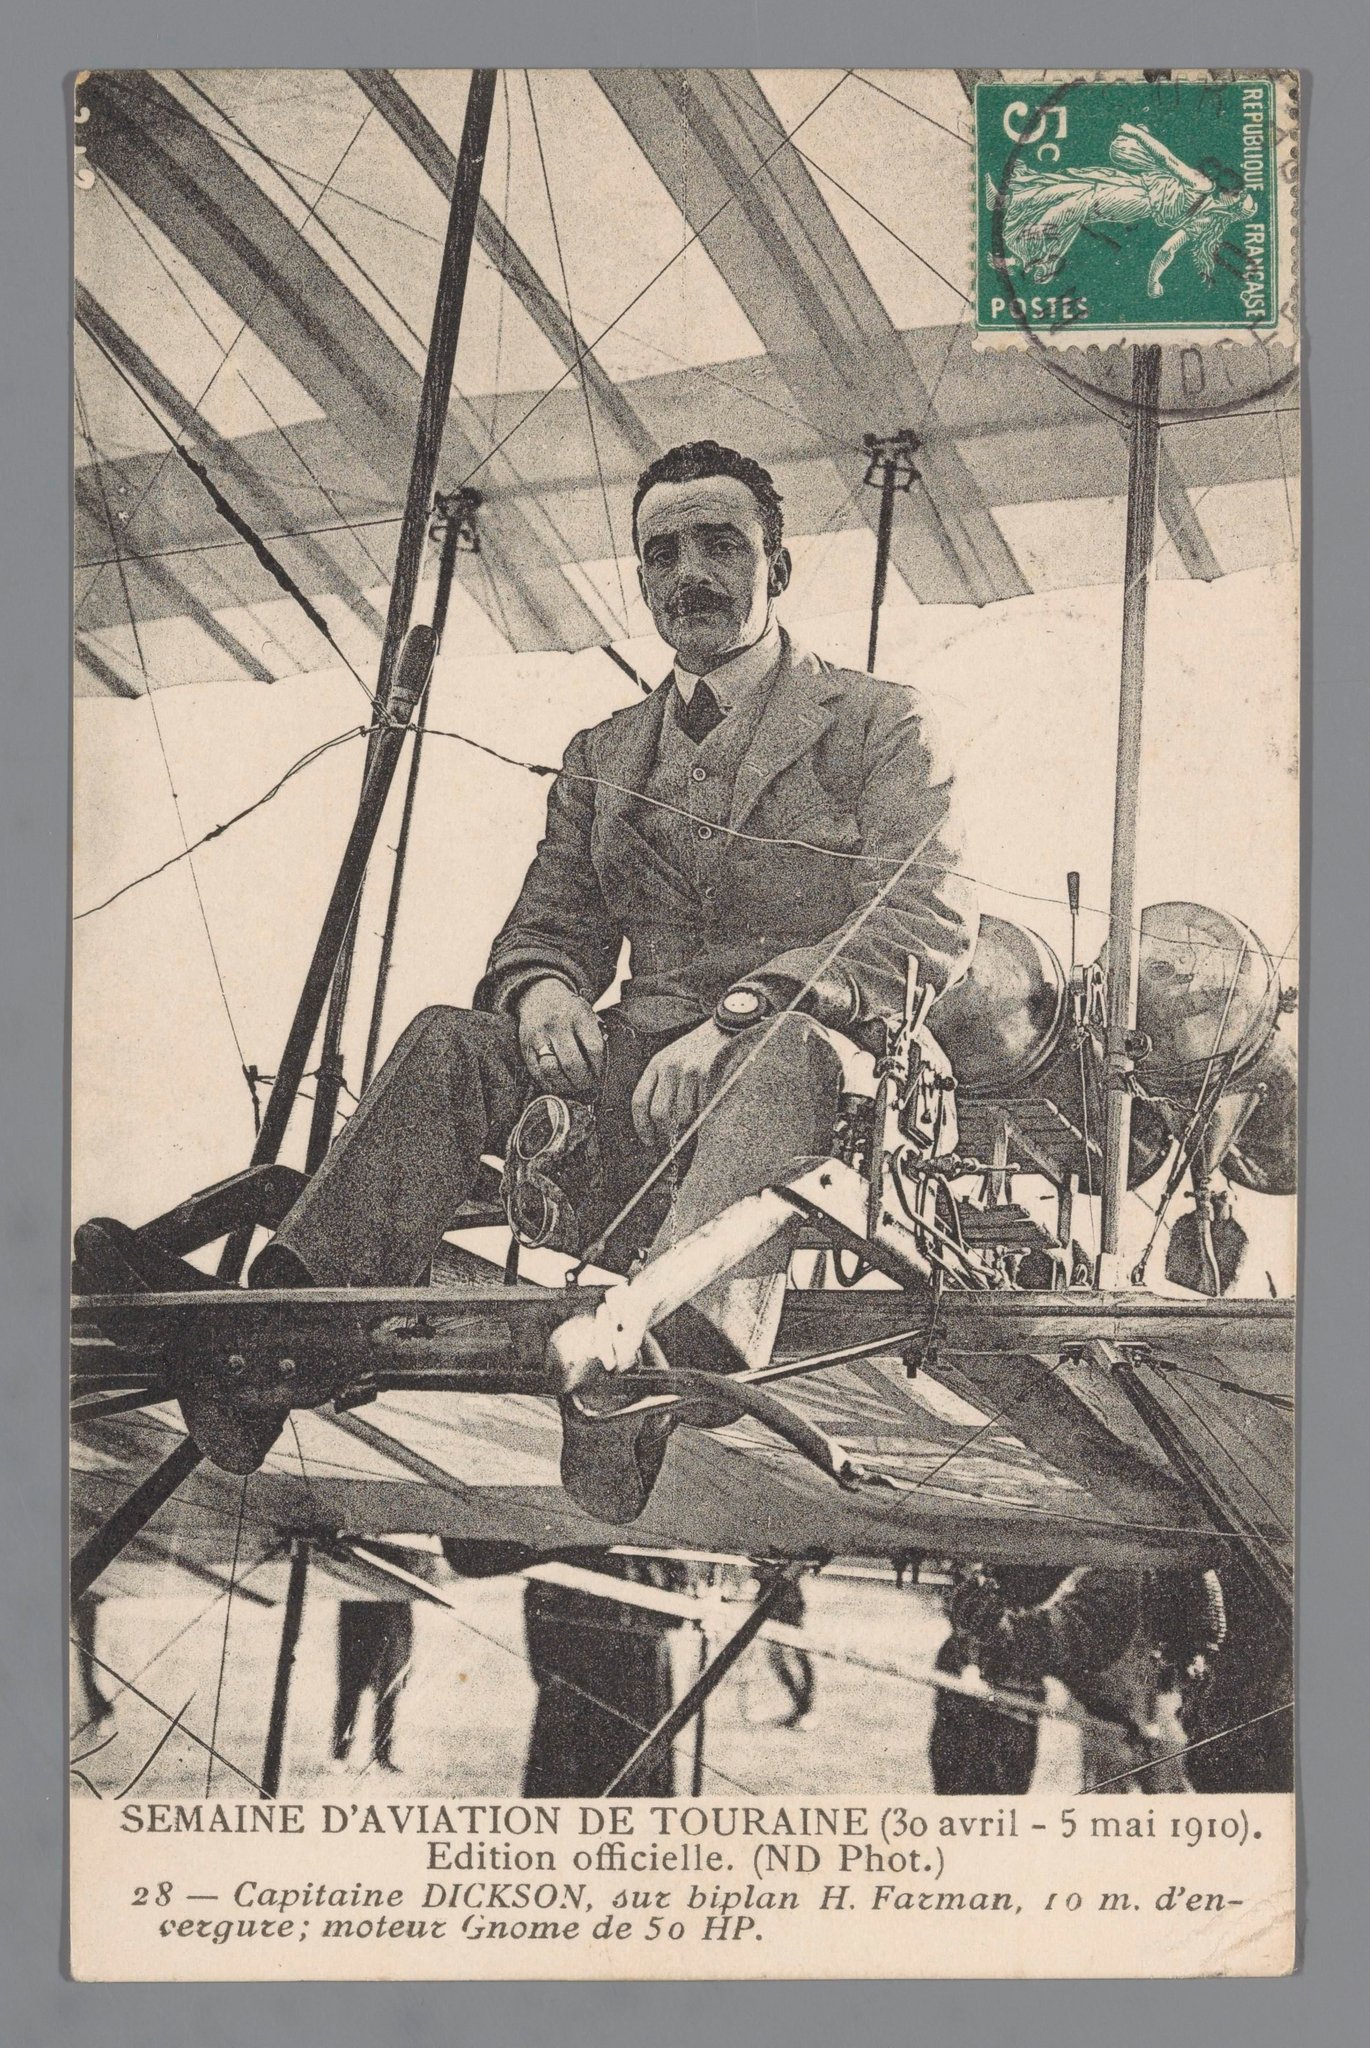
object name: ansichtkaart, prentbriefkaart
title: Portret van Bertram Dickson op het vliegtuig van Henri Farman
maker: Anonymous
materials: paper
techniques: photograph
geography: reims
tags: aircraft, aeroplane, pilot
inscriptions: inscription: ‘Esnault Montrèsor Indre et Loire France L E 984’, number: ‘28’, inscription: ‘Monsieur J. F Milders (...) Delft Hollande’, inscription: ‘Semaine d'aviation de Touraine (30 avril - 5 mai 1910)’